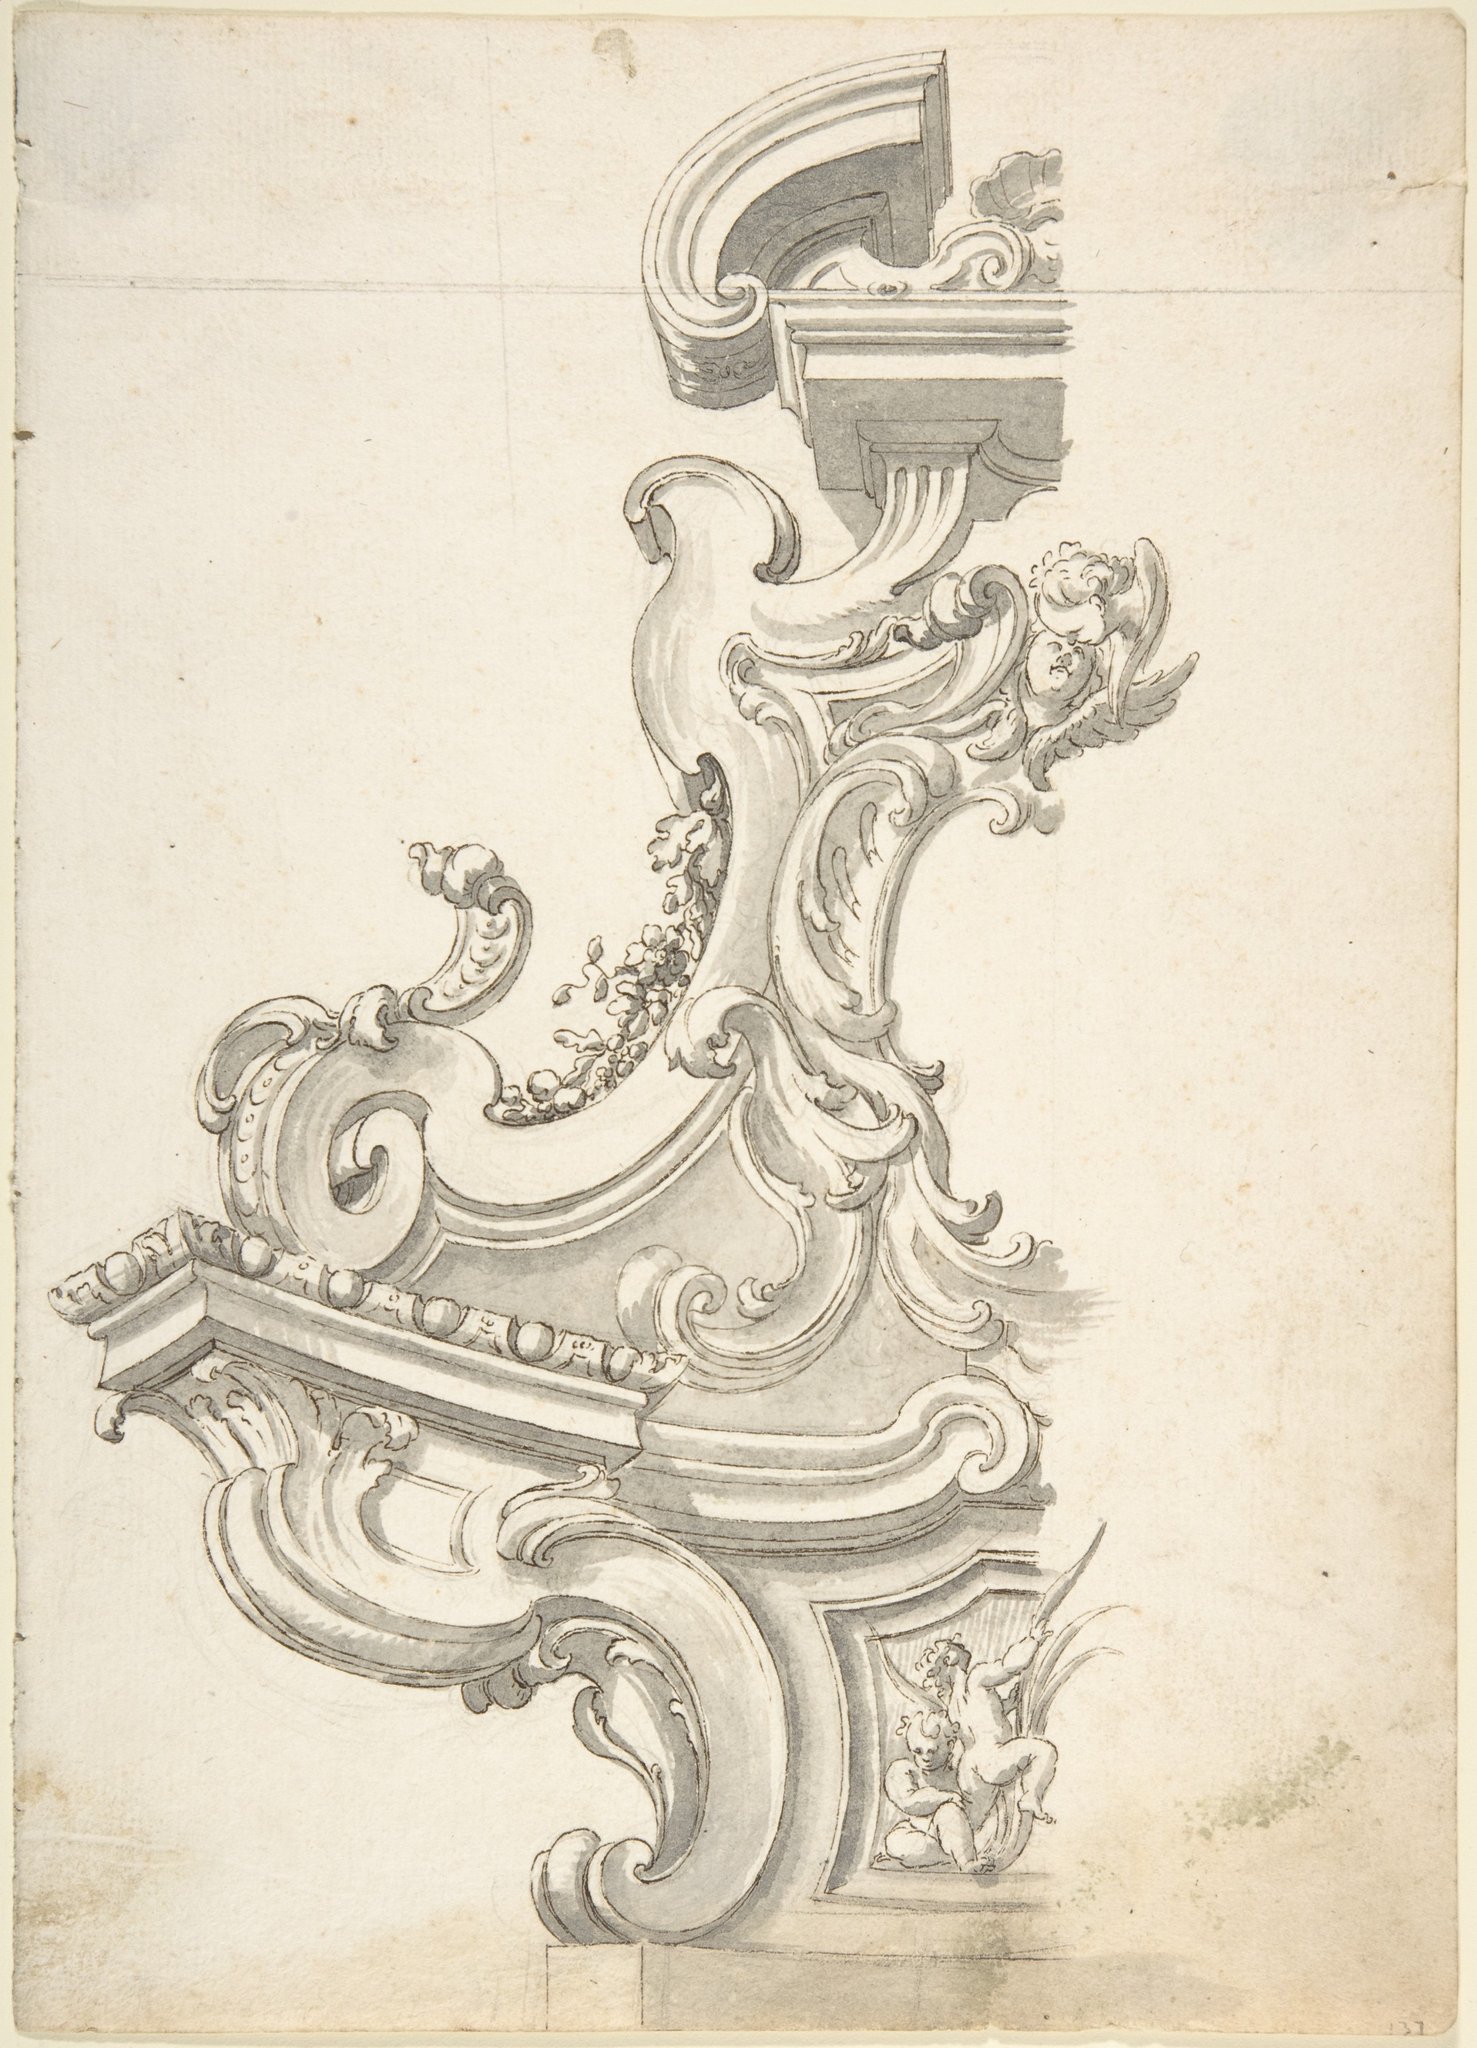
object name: drawing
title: Design for One Half of an Overdoor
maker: anonymous, italian, piedmontese, 18th century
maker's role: artist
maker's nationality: italian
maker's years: 1700-1800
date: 1700-1780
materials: graphite, ink, drawing material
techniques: brush, pen, wash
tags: architecture